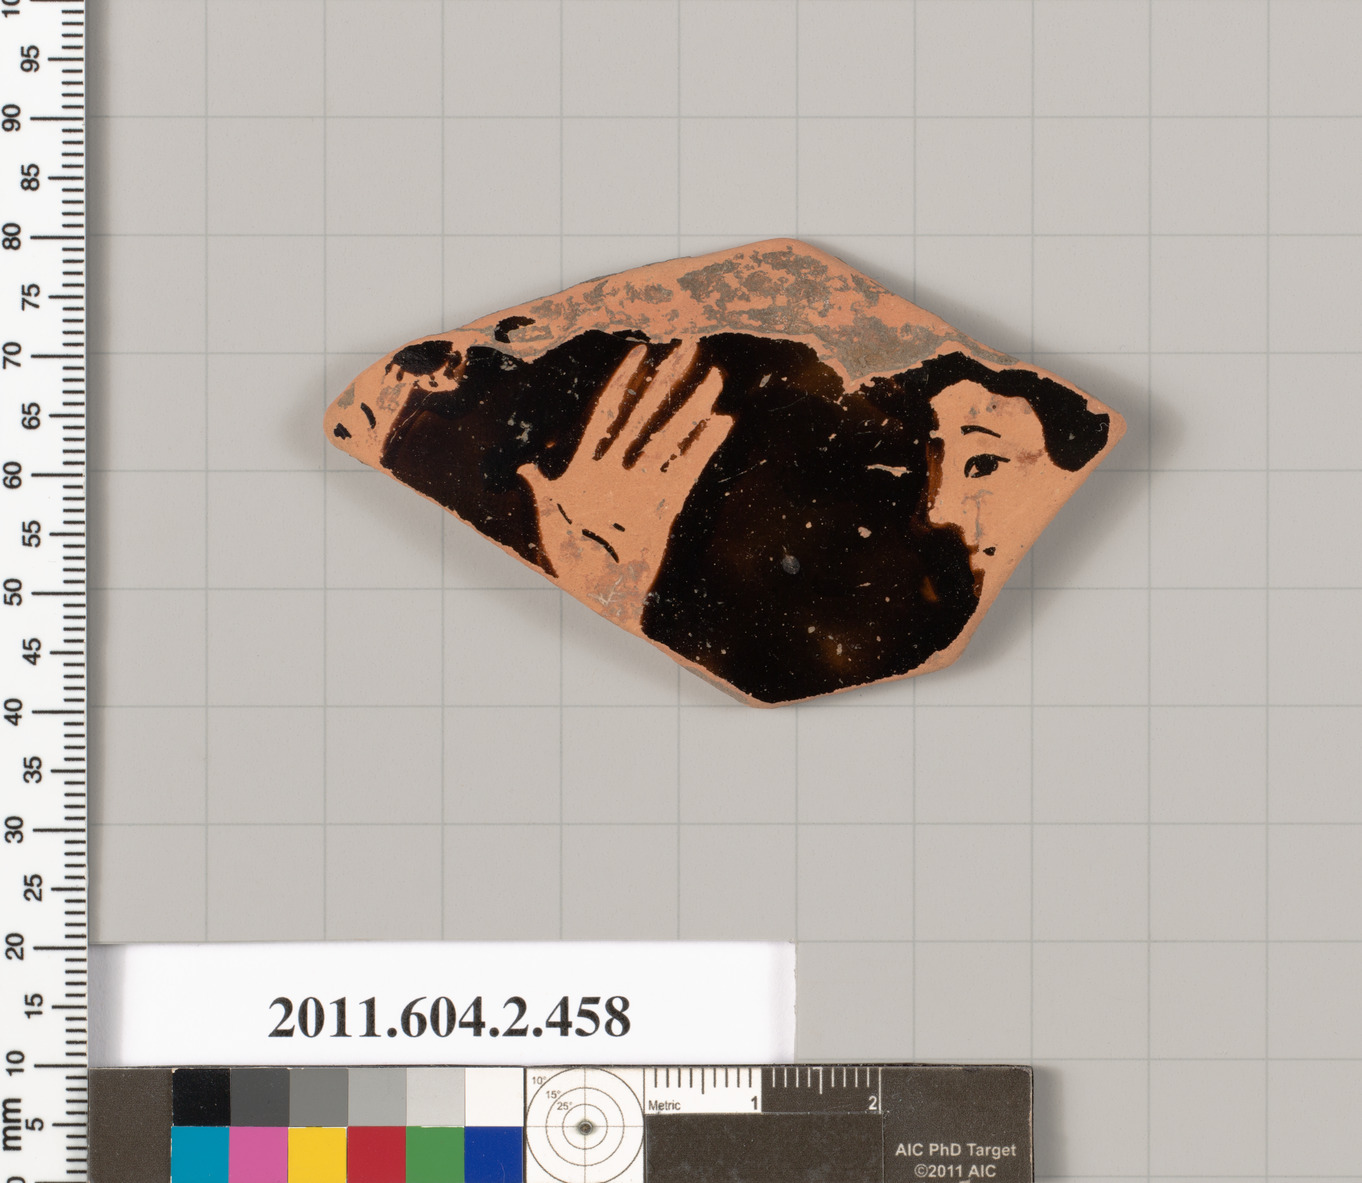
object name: column krater fragment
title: Terracotta fragment of a column-krater (bowl for mixing wine and water)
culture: greek, attic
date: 460-440 BCE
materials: terracotta